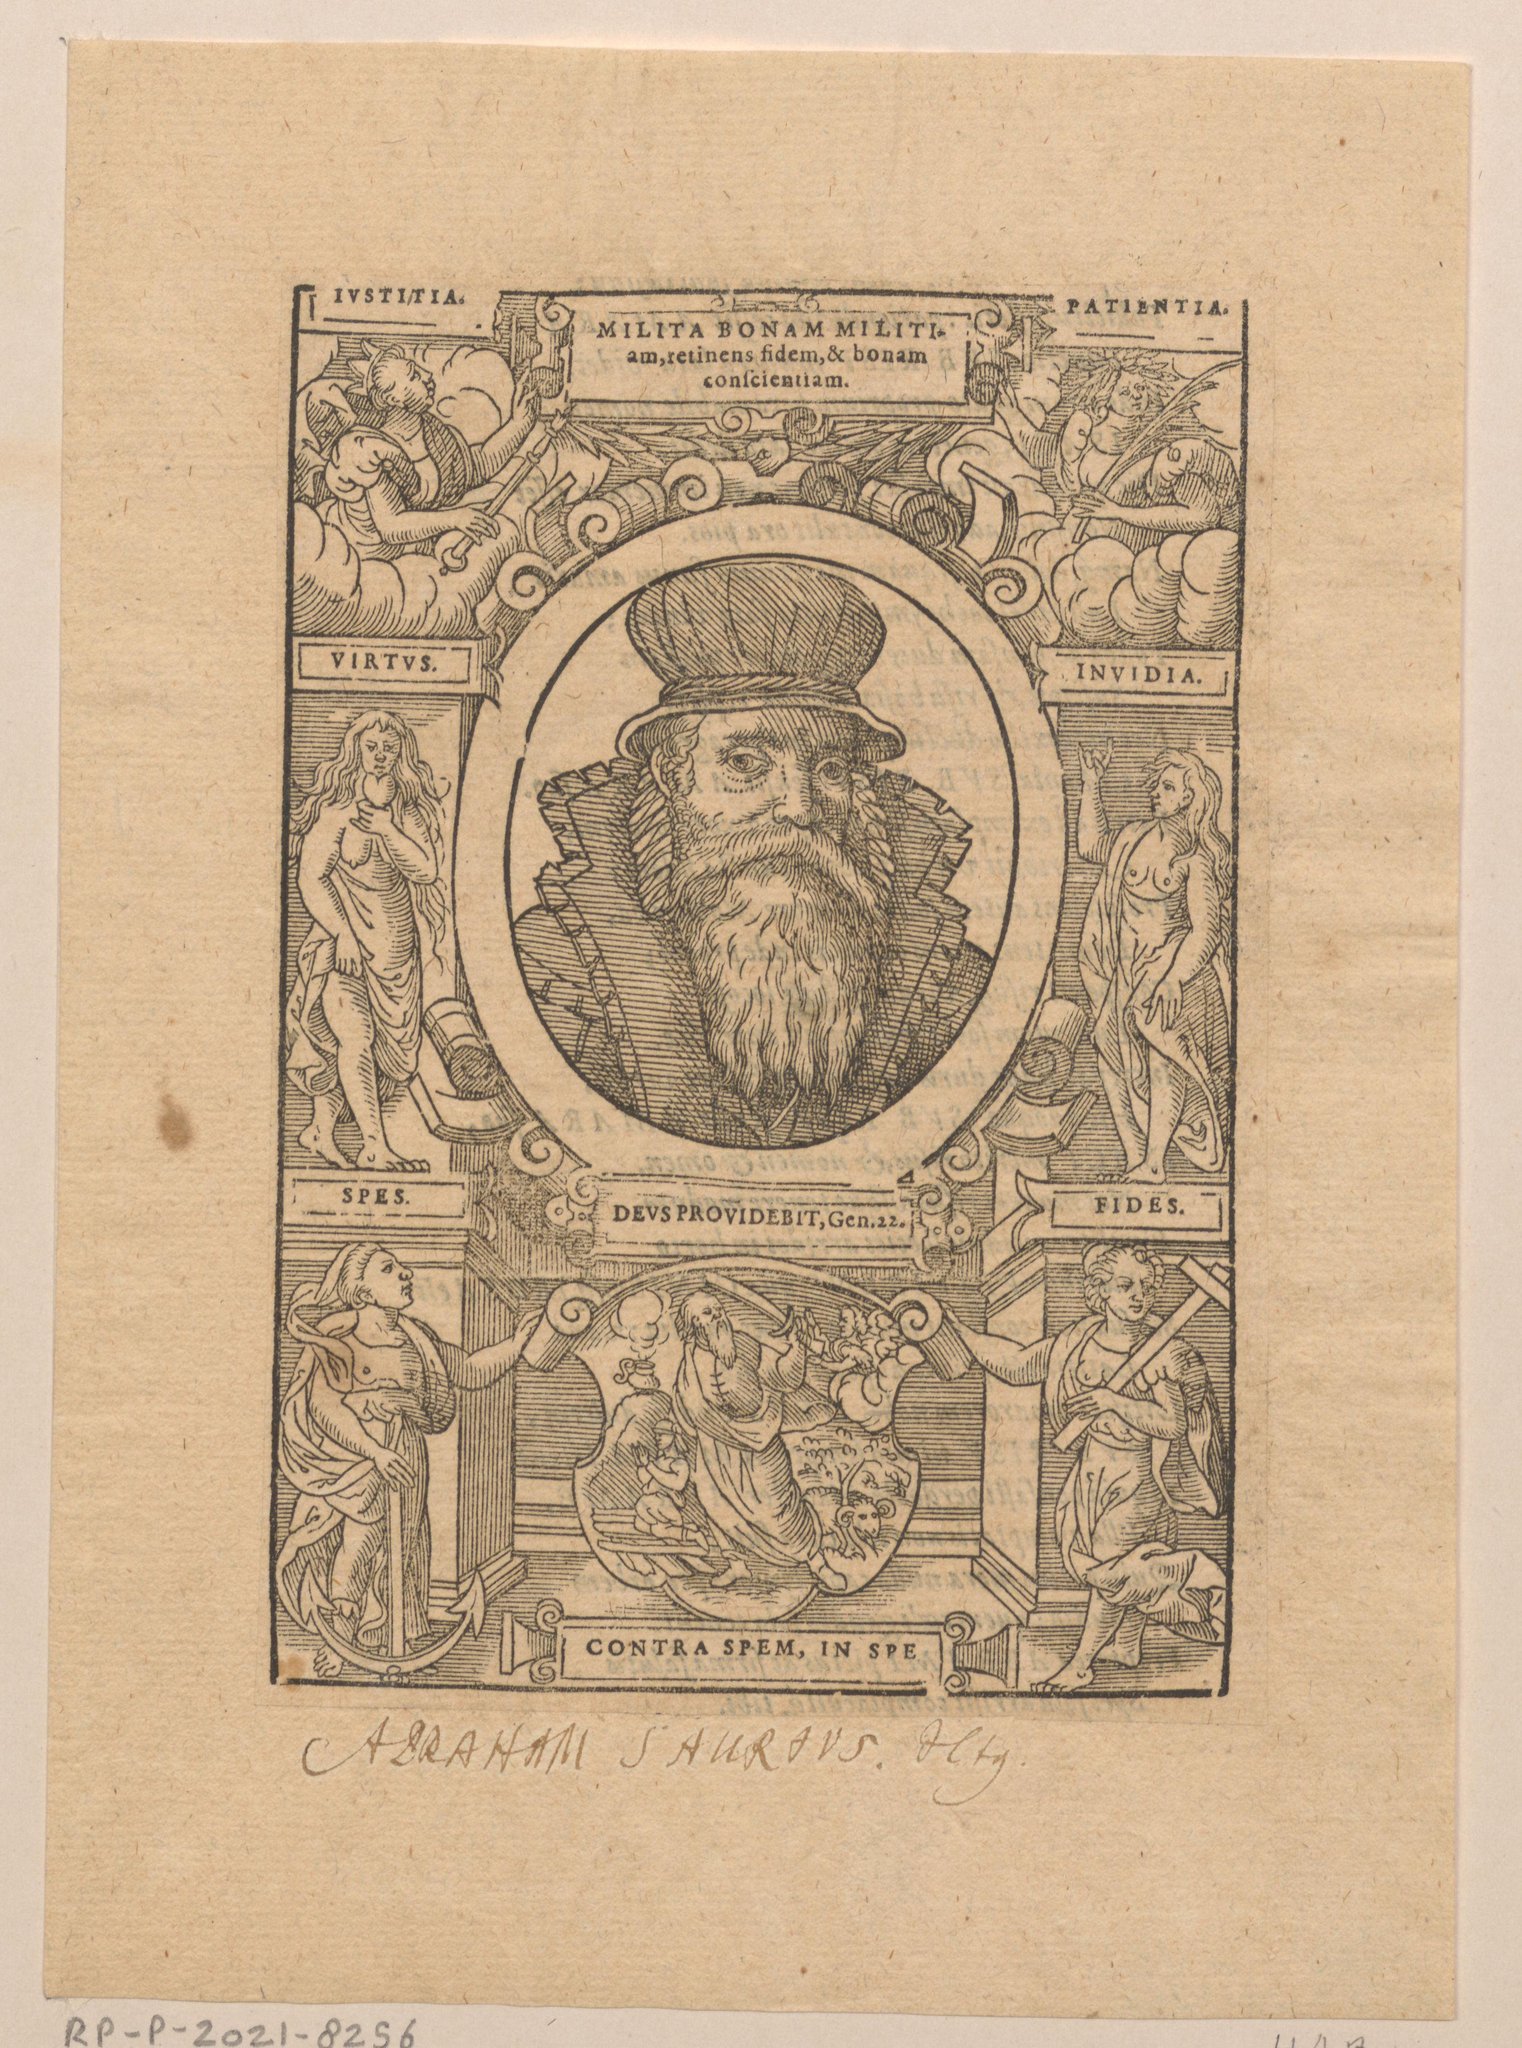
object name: print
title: Portret van Abraham Saur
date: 1594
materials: paper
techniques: letterpress printing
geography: frankfurt am main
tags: envy; 'invidia' (ripa) ~ personification of one of the seven deadly sins, pride; 'superbia' (ripa) ~ personification of one of the seven deadly sins, historical persons, law and jurisprudence, the four cardinal virtues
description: Prent uit: Saur, Abraham. Dives notariorum penus, das ist ein new, schön, außerlesen Formular (...). Frankfurt am Main: erven Nikolaus Basse 1607.